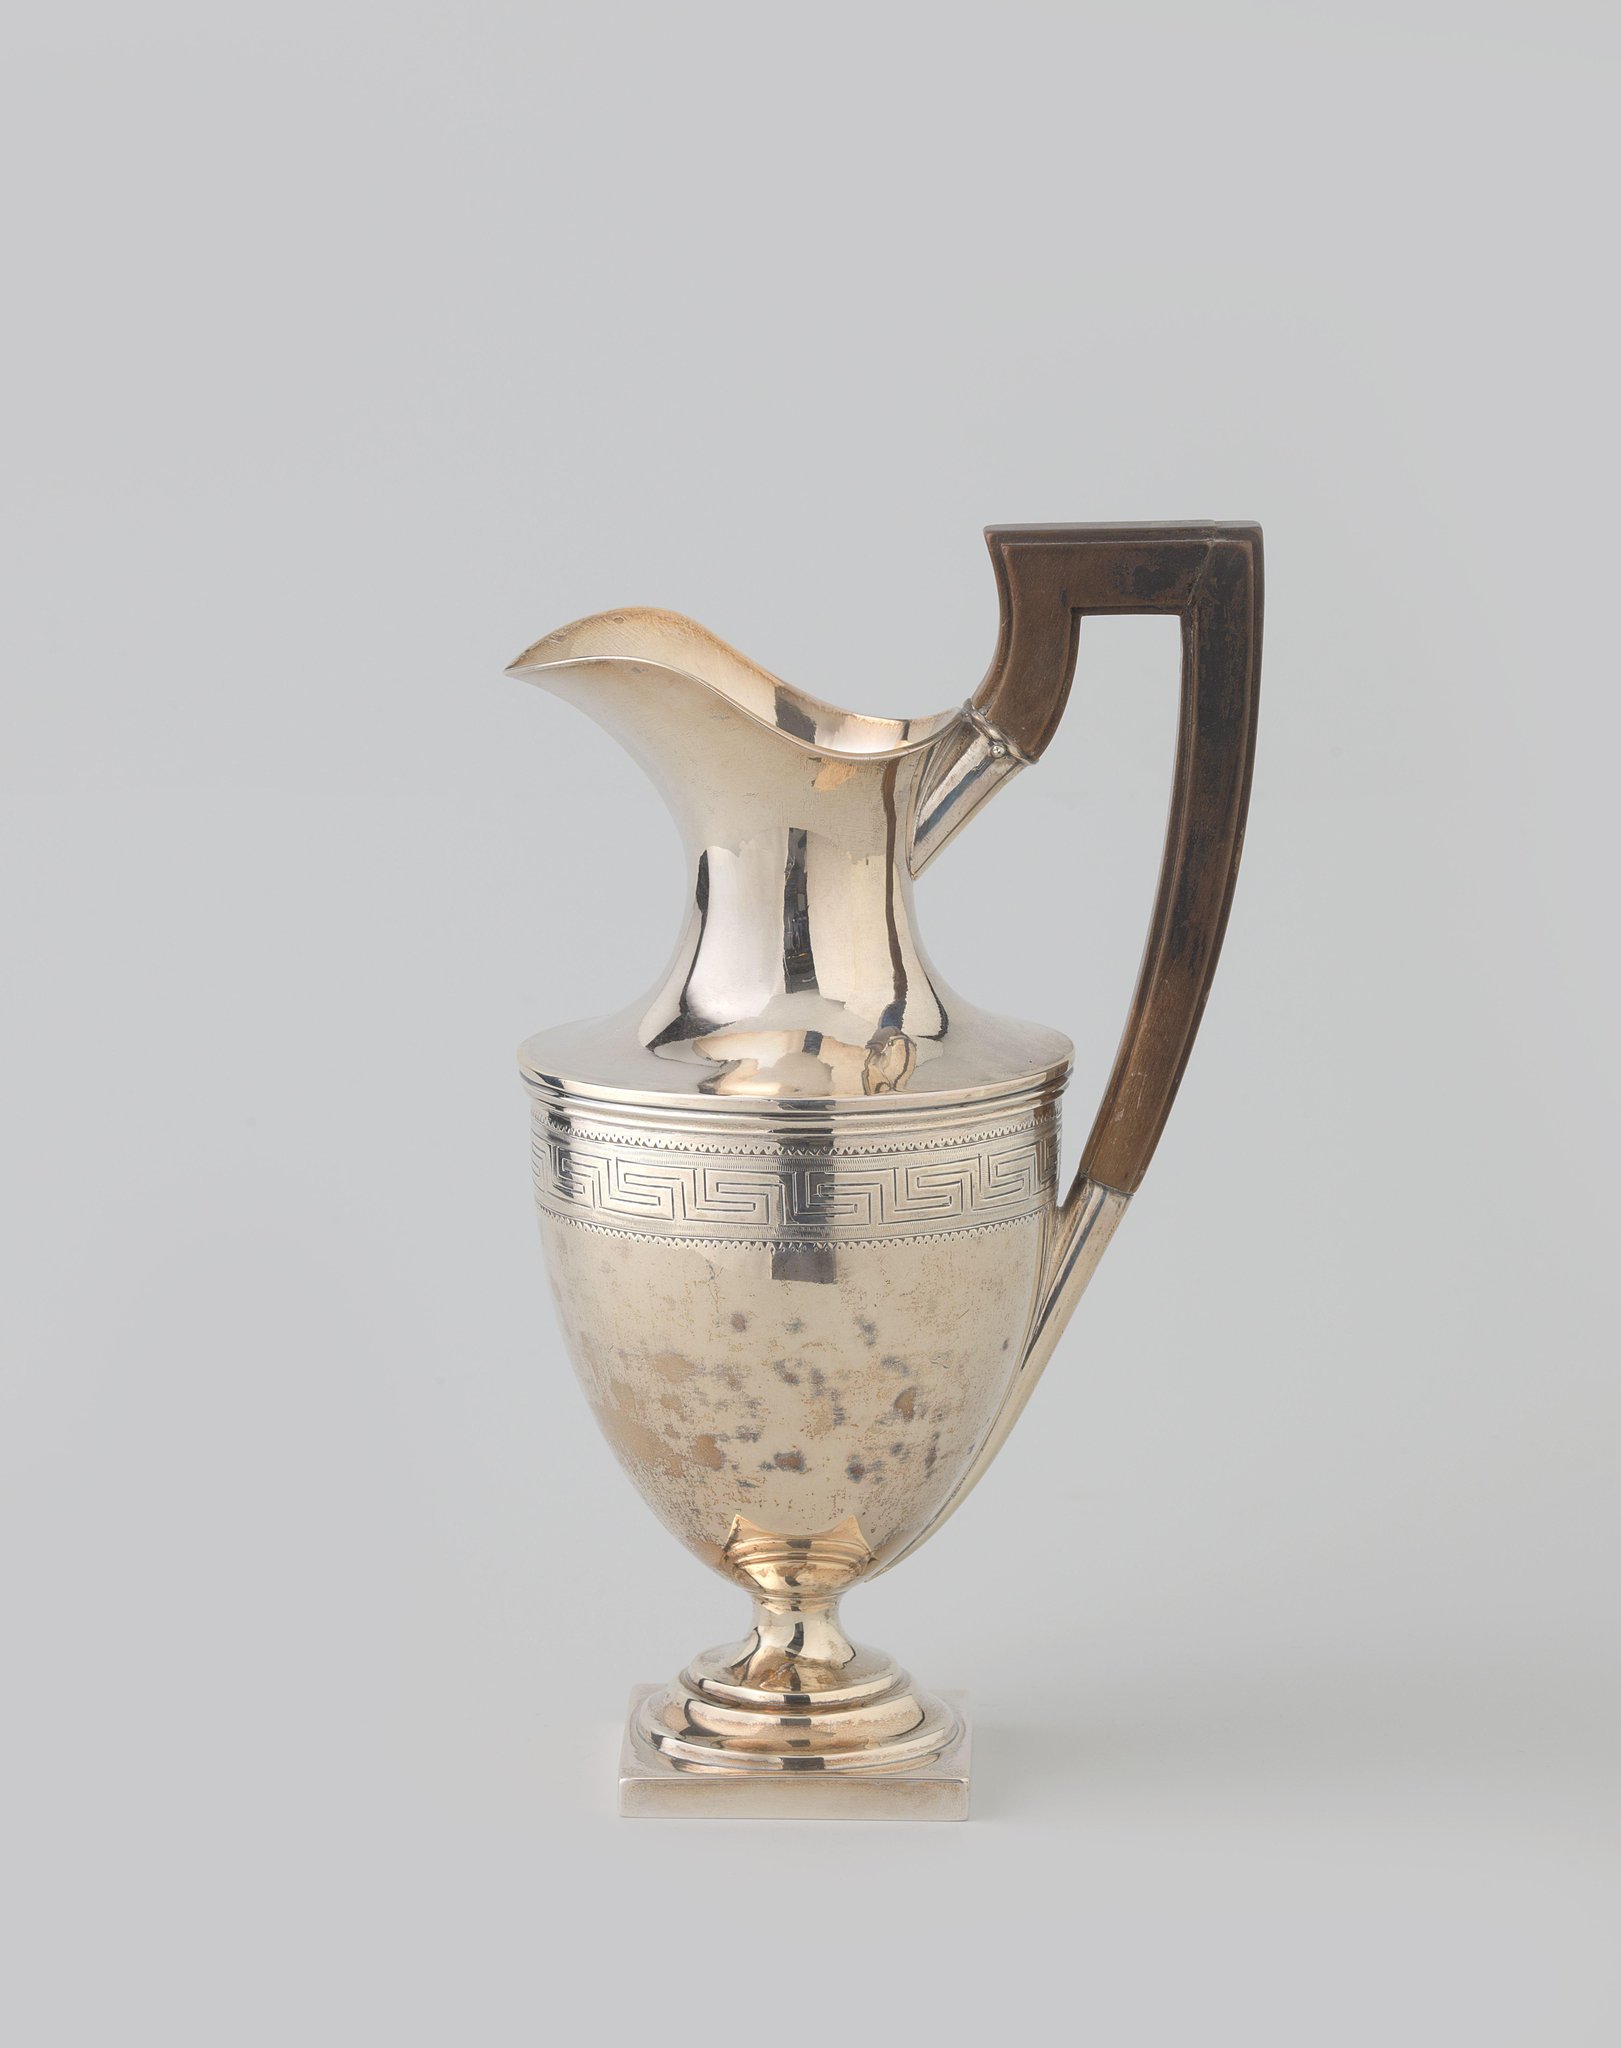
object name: ewer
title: Kan van zilver, rond op vierkante, rechtwandige basis. Versierd met meanderrand. Oor van hout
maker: Anonymous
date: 1785-1800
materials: silver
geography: lausanne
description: Ronde kan van zilver op een vierkante rechtwandige basis. Het houten oor is tegenover de schenktuit geplaatst. Versierd met een meanderrand.